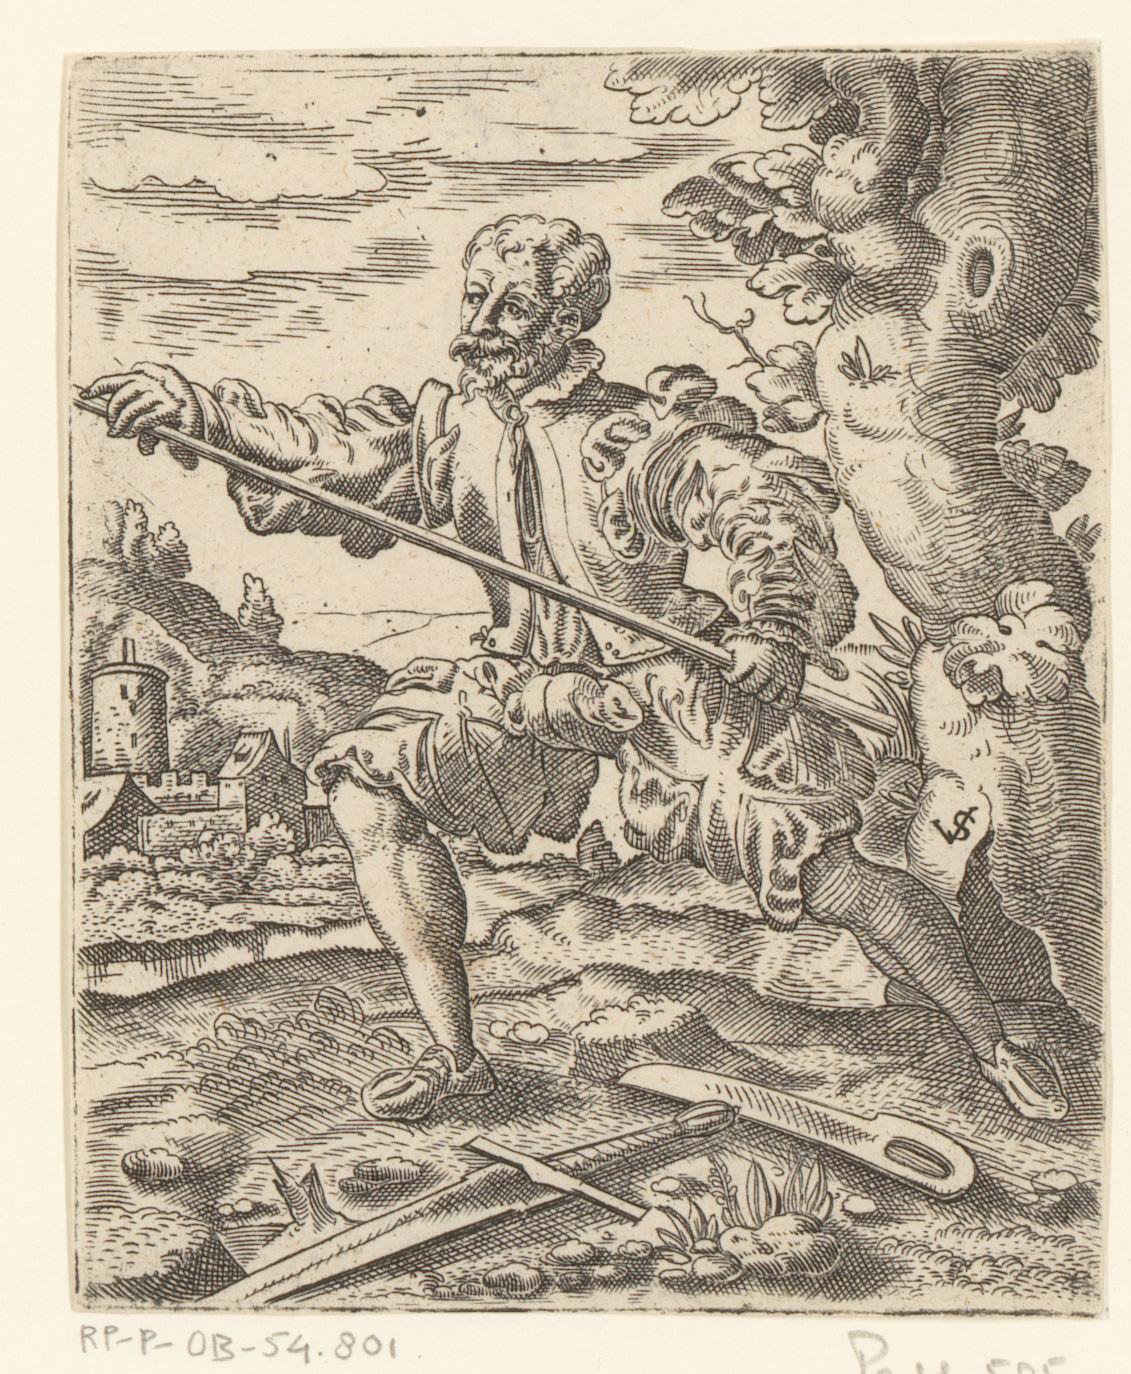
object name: print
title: Landsknechten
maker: virgilius solis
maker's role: draughtsman, print maker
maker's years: 1514-1562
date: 1524-1562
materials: paper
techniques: engraving, etching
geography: nuremberg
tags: city-view, and landscape with man-made constructions, trees, the soldier; the soldier's life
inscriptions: collector's mark: Lugt 2228, number: ‘147’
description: Prent maakt deel uit van een serie van zeven prenten met landsknechten. In de collectie Rijksmuseum bevinden zich twee prenten uit de serie.